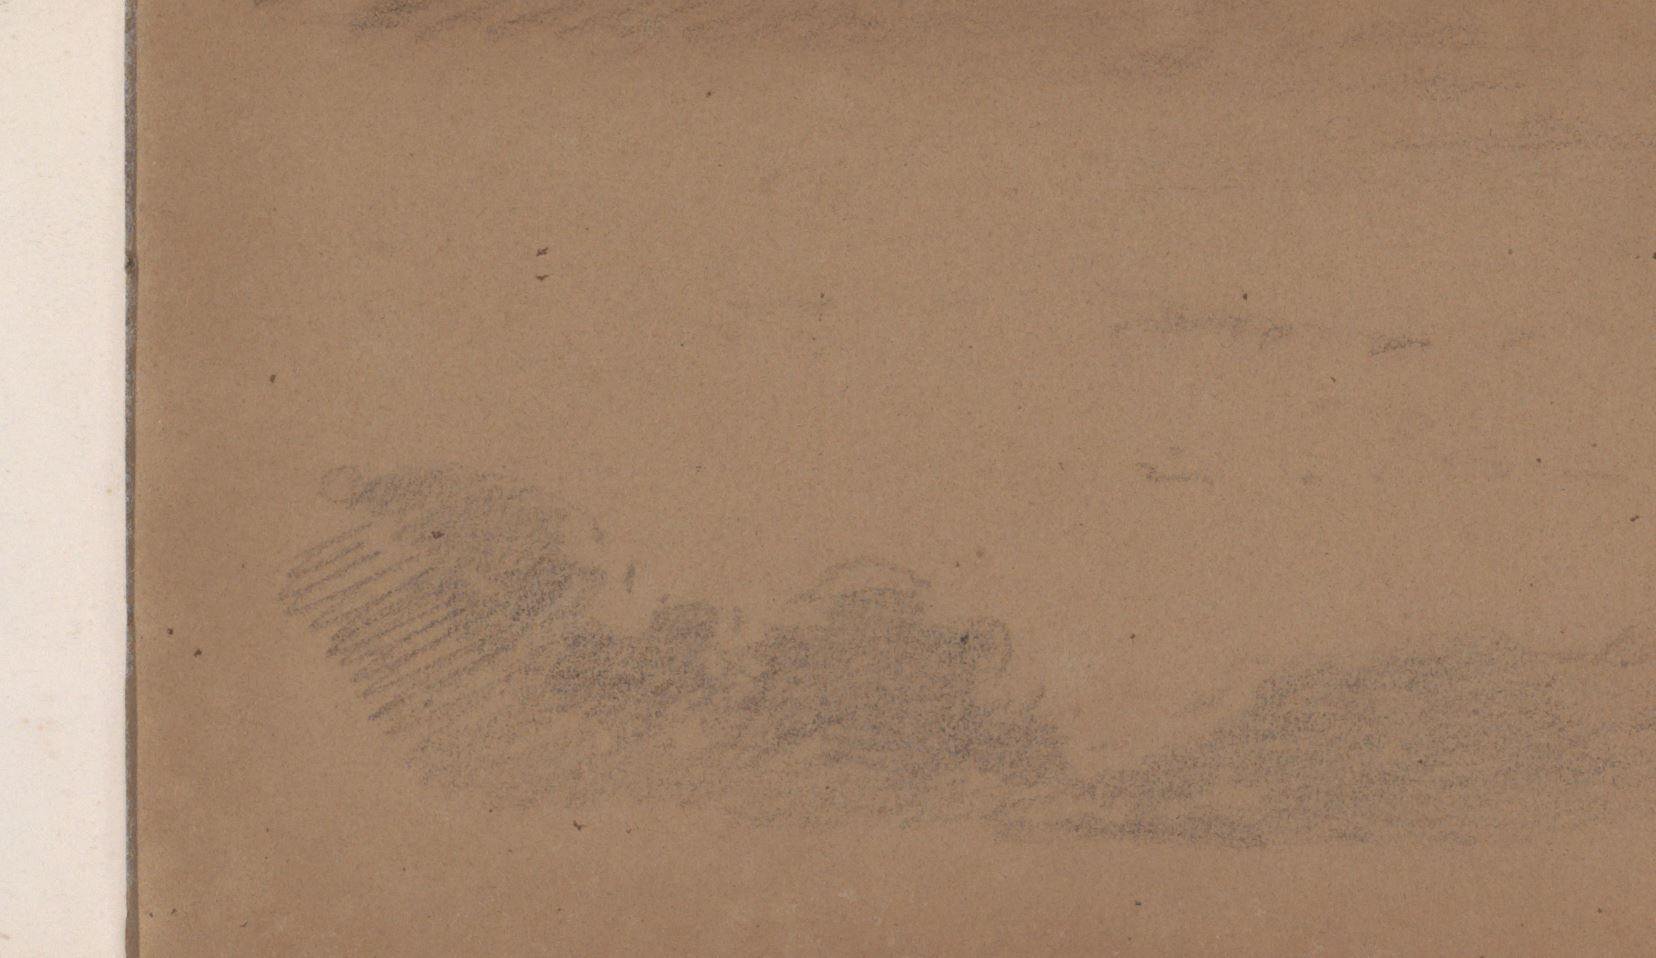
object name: sketchbook leaf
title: Wolken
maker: maria vos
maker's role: draughtsman, painter, print maker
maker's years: 1824-1906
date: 1863-1864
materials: paper, pencil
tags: clouds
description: Blad 31 recto uit een schetsboek met 41 bladen.